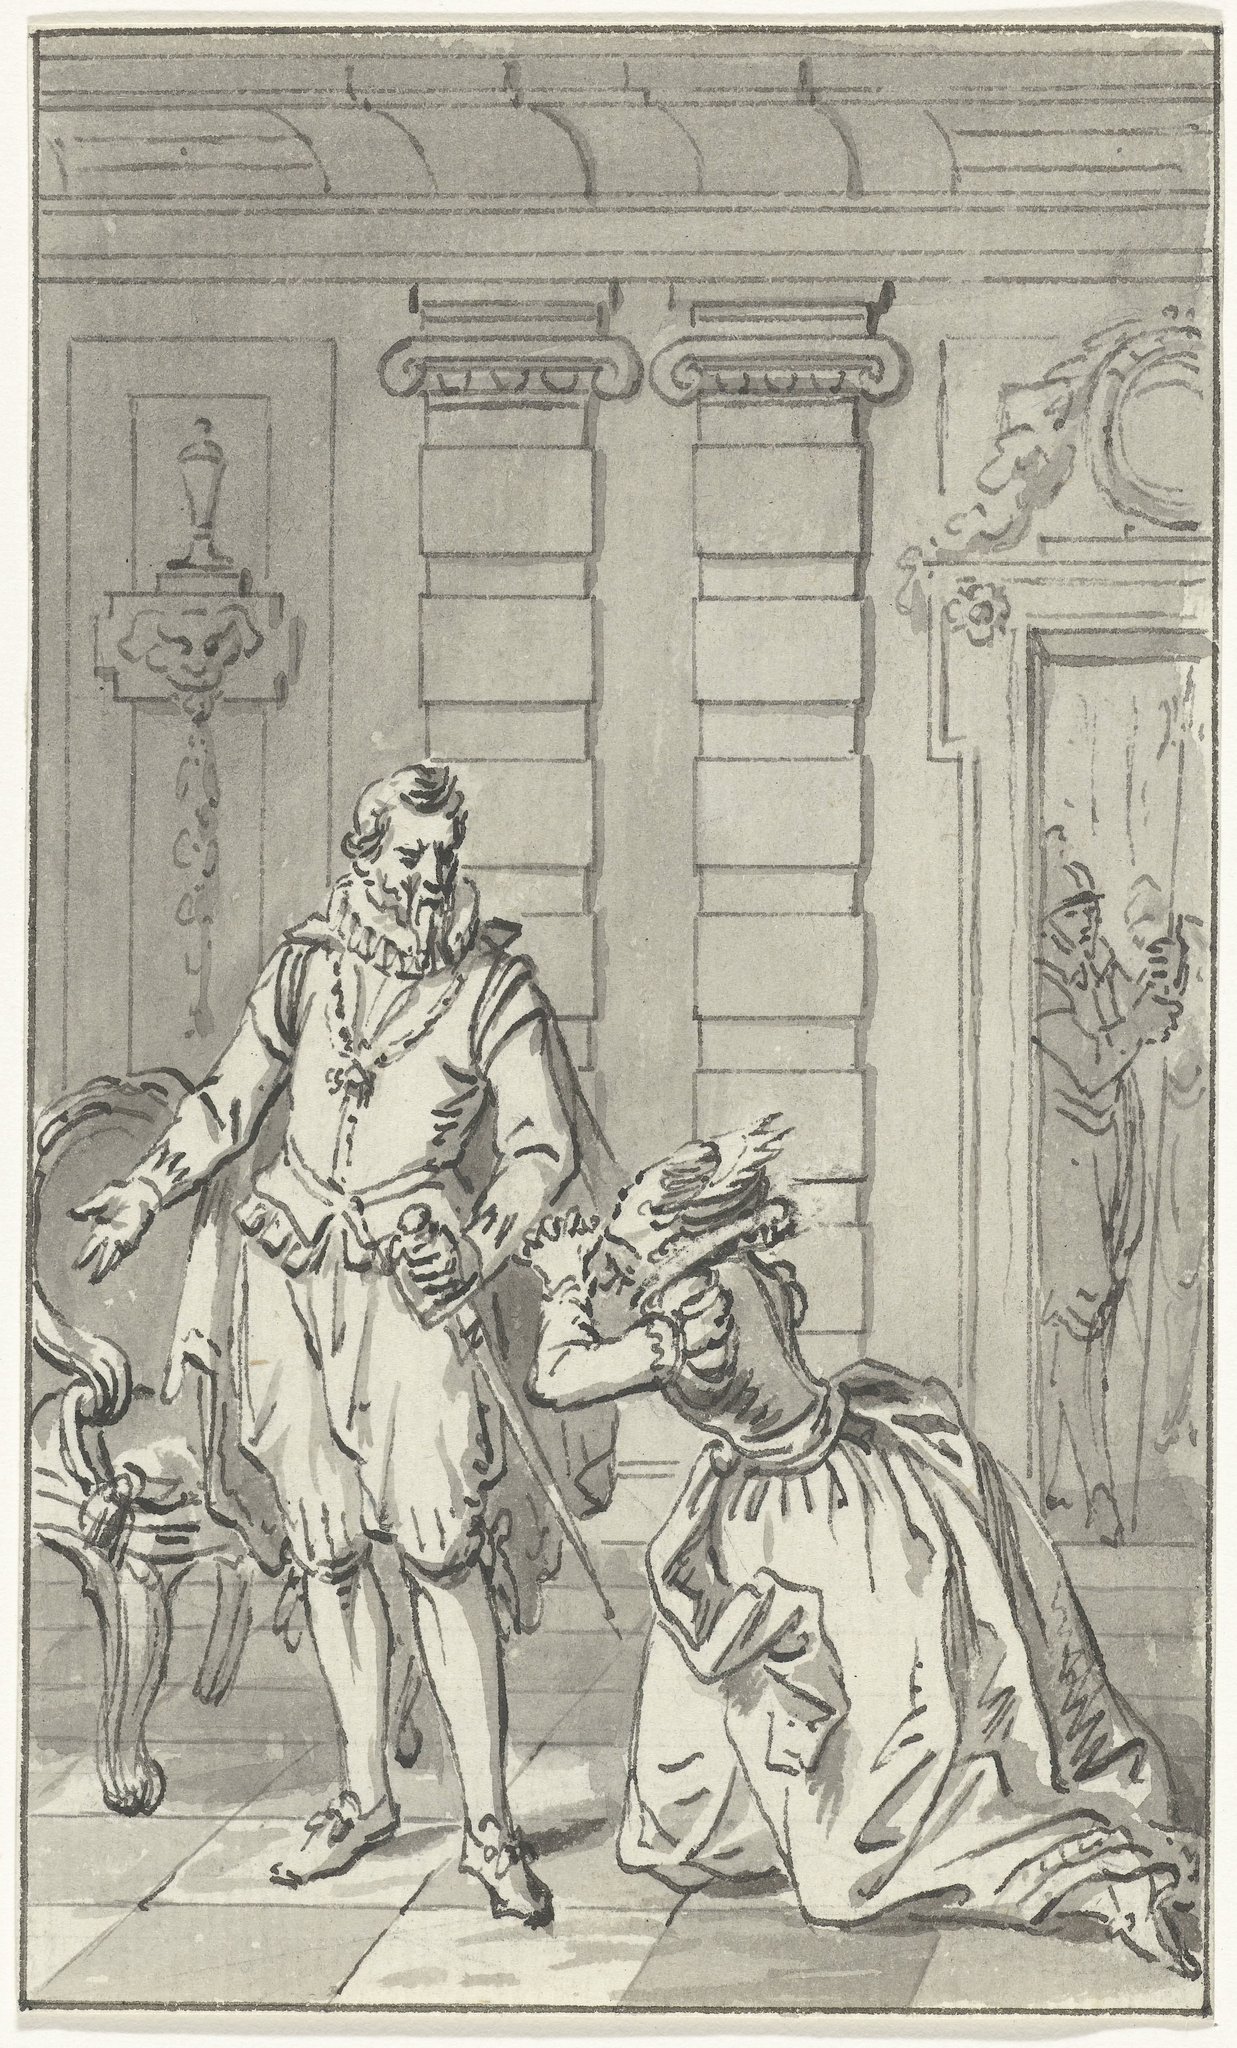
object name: historieplaat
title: Sabine van Beieren smeekt Alva haar man, de graaf van Egmond, vrij te laten, juni 1568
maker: jacobus buys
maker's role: draughtsman, print maker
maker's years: 1724-1801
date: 1783-1785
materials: ink, paper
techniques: brush, pen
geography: netherlands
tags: fernando álvarez de toledo (3rd duke of alba), antwerp, brussels, earl, historical persons, granting mercy; free pardon, historical events and situations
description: Interieur met knielende vrouw voor man. Sabina van Beieren smeekt de hertog van Alva om genade voor haar ter dood veroordeelde man, de graaf van Egmond, begin juni 1568. Ontwerp voor een prent.